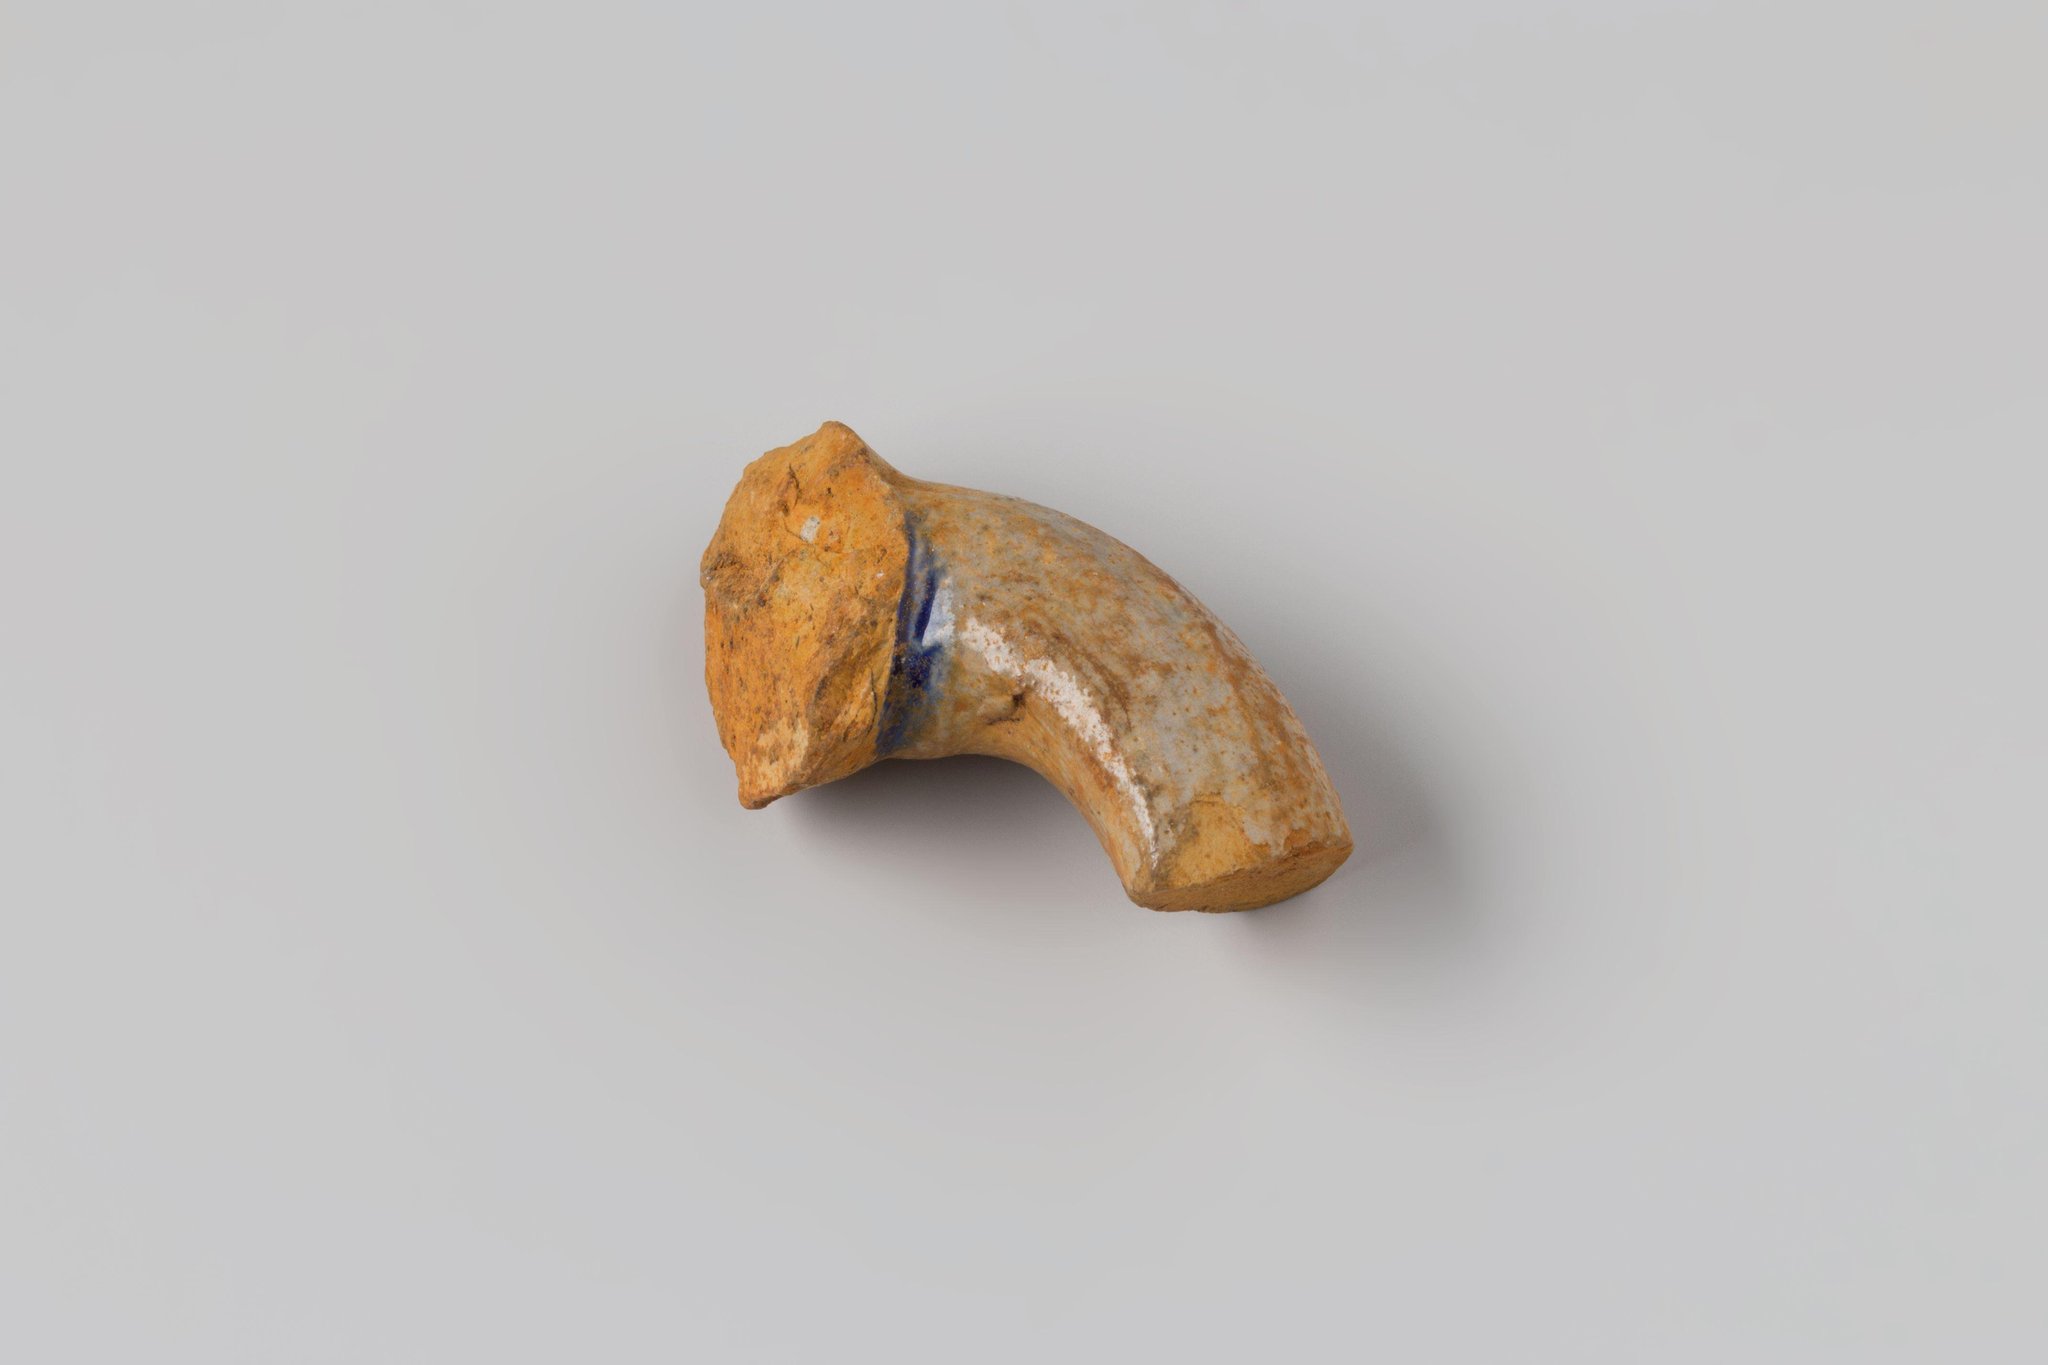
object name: sherd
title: Oor van een pot uit het wrak van de Oost-Indiëvaarder Hollandia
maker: Anonymous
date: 1700-1743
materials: stoneware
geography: westerwald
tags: verenigde oostindische compagnie, hollandia (schip), annet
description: Stoneware, Rhenish, Westerwald, pot; of handle, sim. NG 1980-27H2624r.